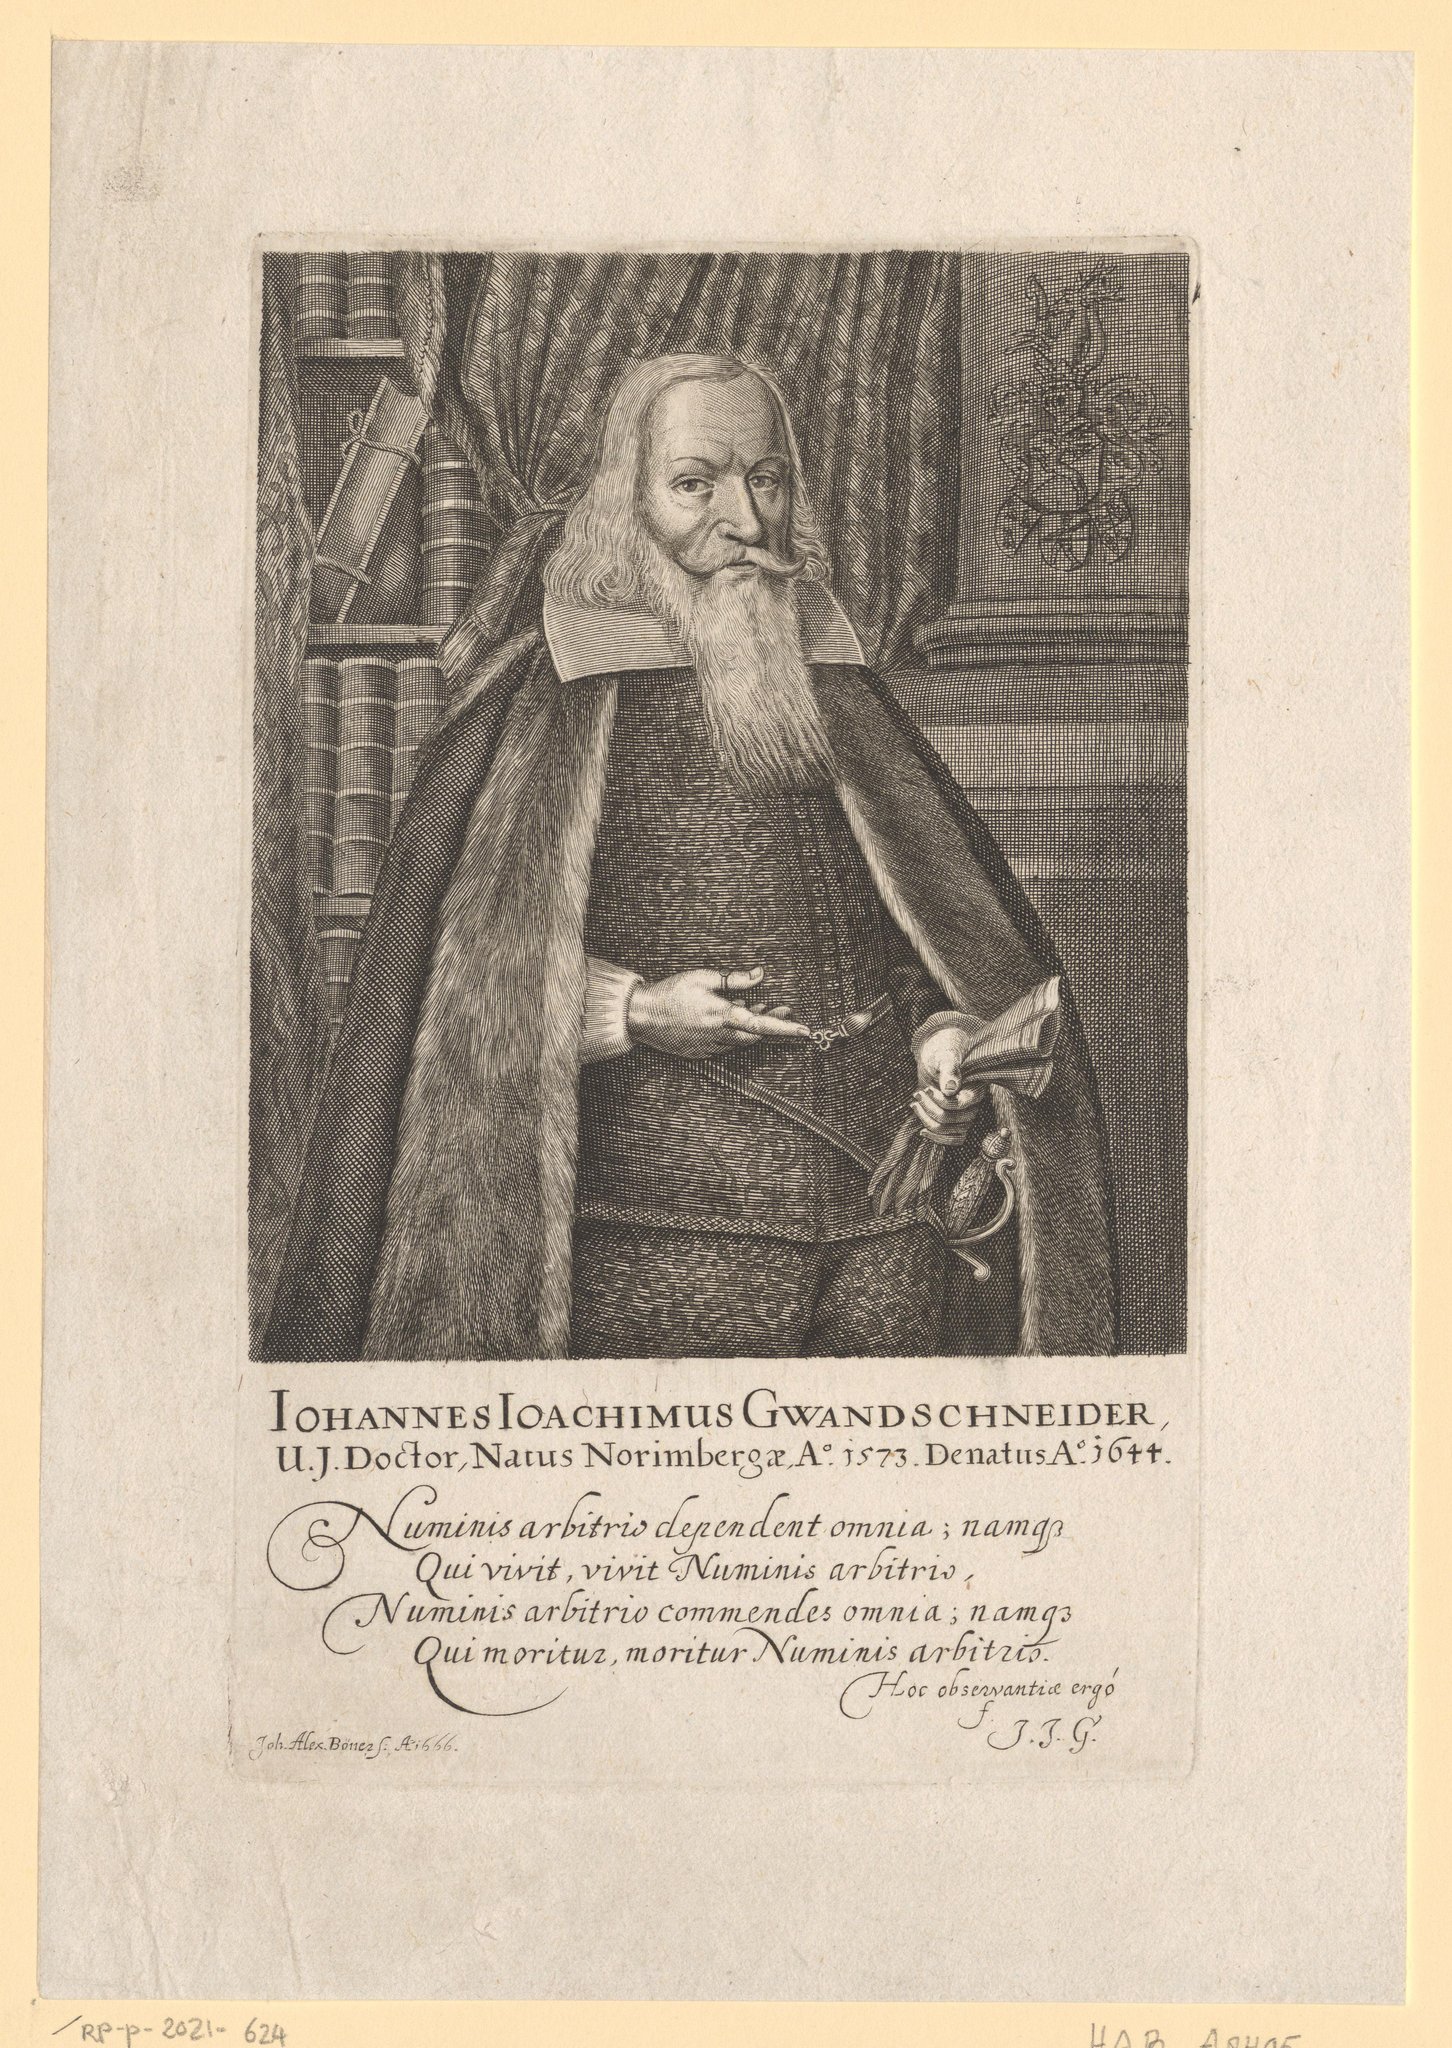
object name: print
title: Portret van Johann Joachim Gwandschneider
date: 1666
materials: paper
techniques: engraving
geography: nuremberg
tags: johann joachim gwandschneider (i), historical persons, lawyer, attorney at law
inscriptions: date